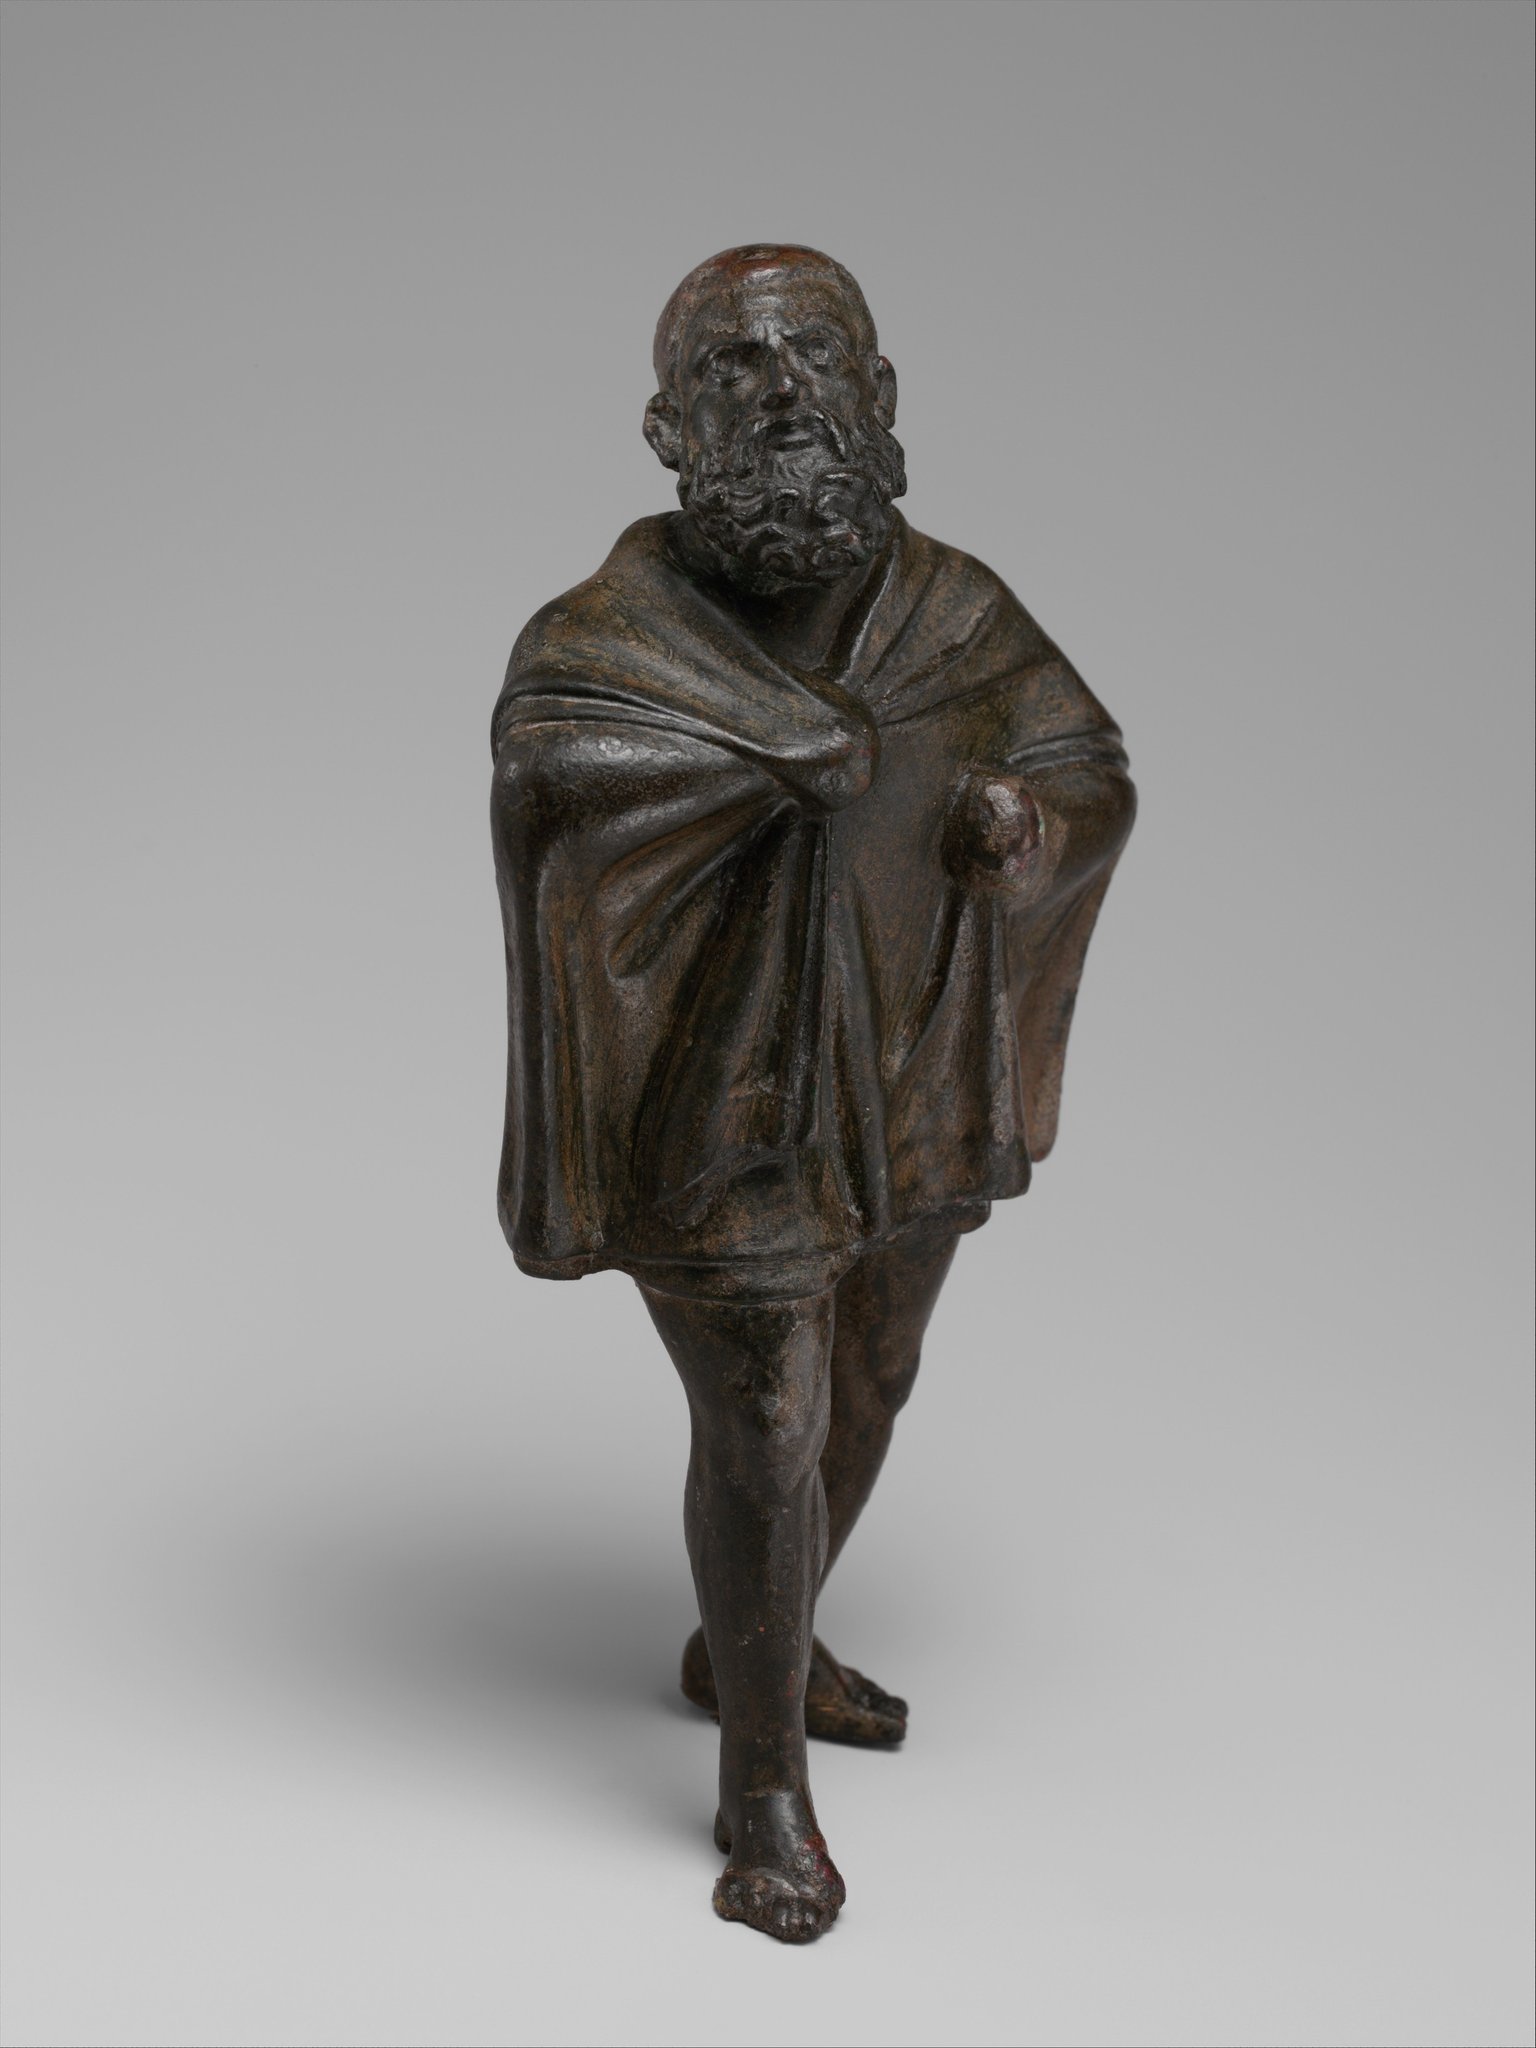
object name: statuette of an actor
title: Bronze statuette of a draped man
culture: greek or roman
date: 100 BCE-100 CE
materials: bronze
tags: men